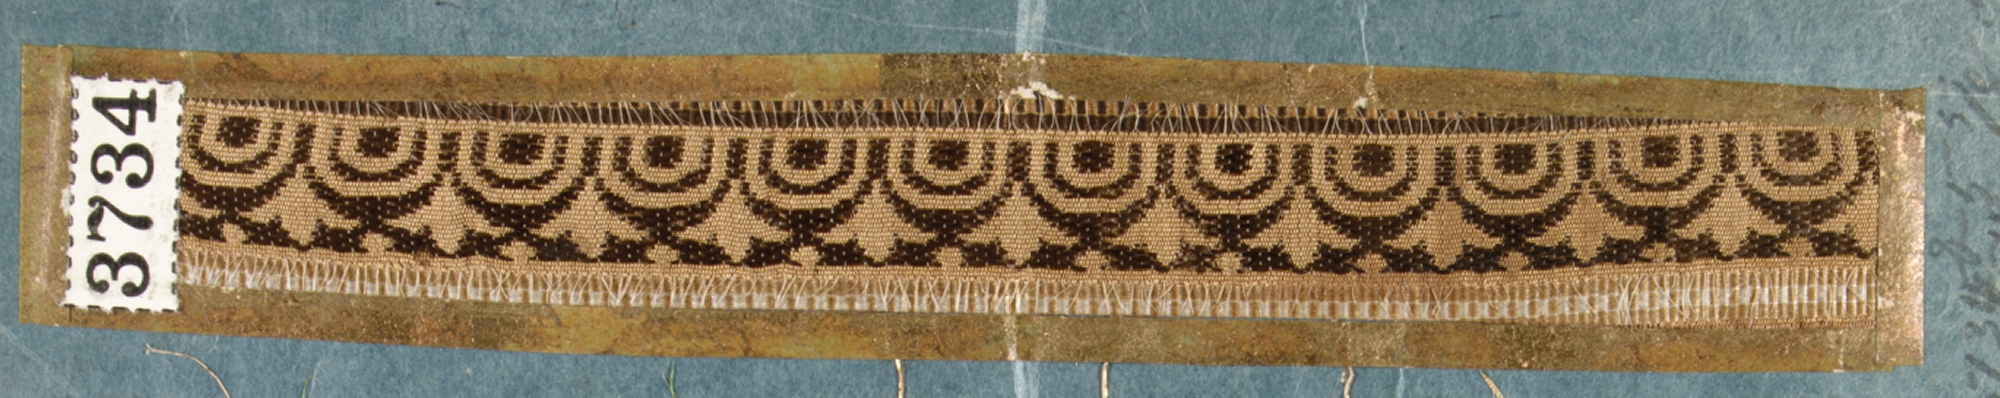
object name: sample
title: Textile Sample from Sample Book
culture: japanese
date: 1801-1900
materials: silk